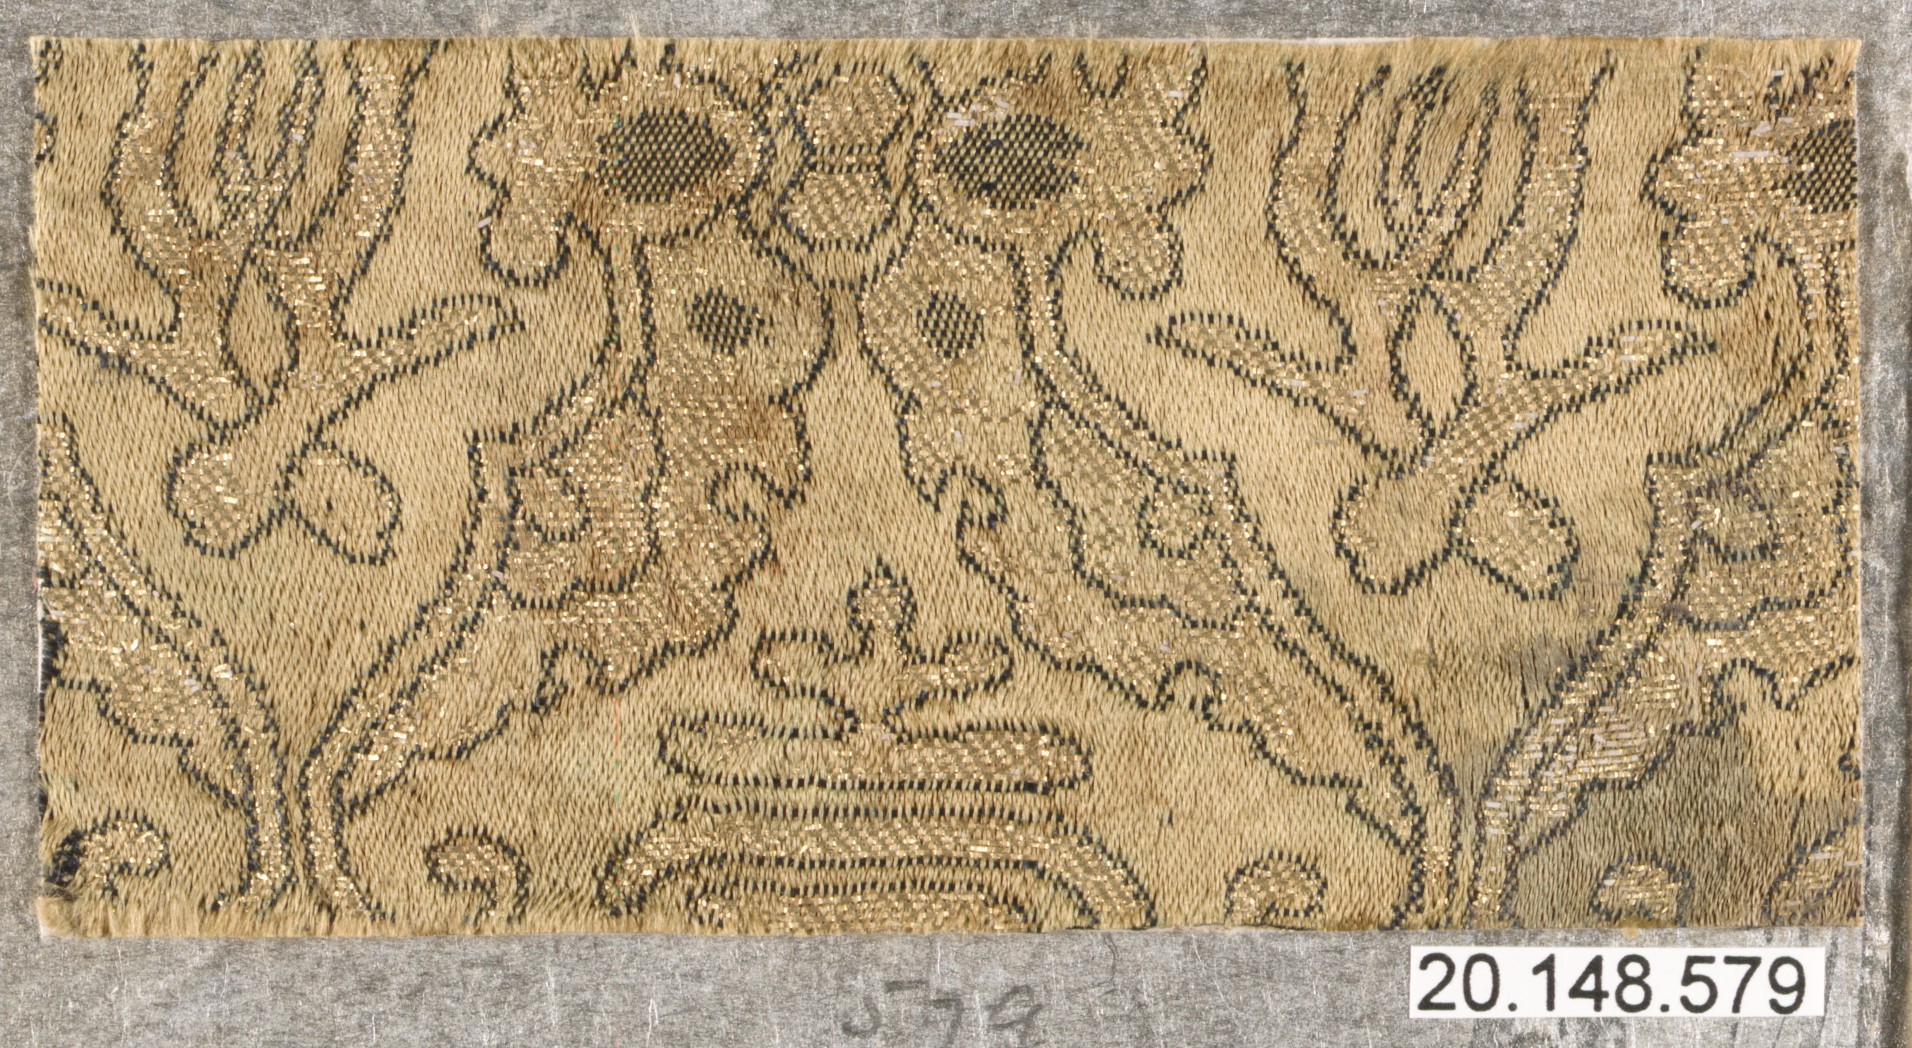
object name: piece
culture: japanese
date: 1701-1800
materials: silk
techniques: compound weave